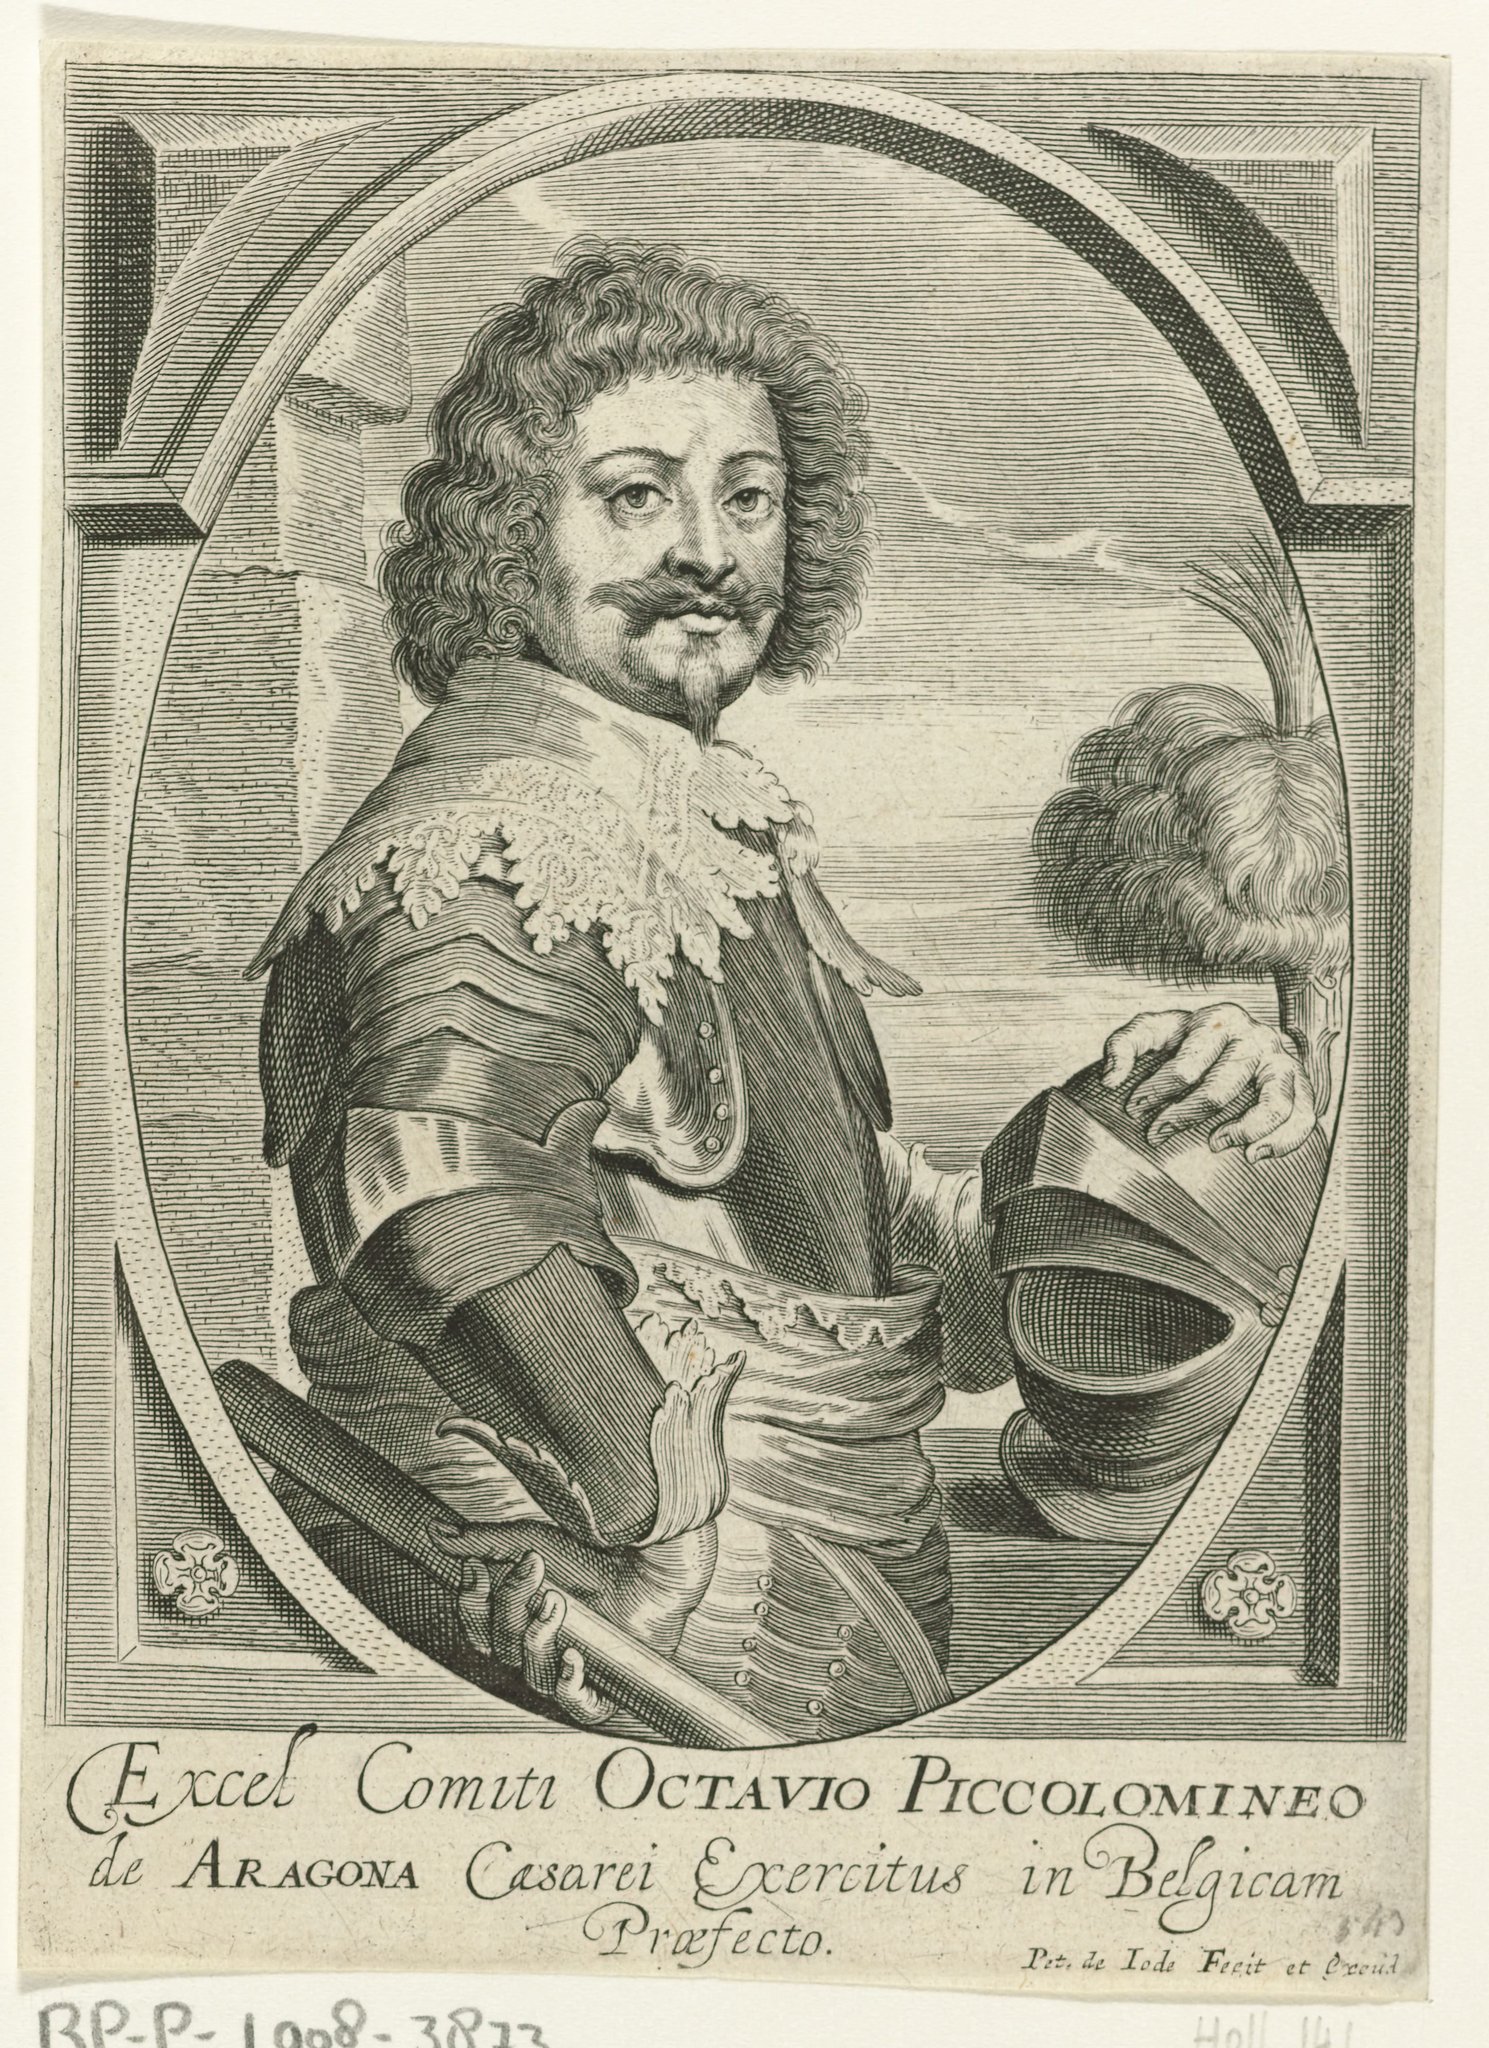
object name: print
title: Theatrum pontificum, imperatorum, regum, ducum, principum, etc.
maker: pieter de jode (ii)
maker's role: draughtsman, print maker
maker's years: 1606-1674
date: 1628-1670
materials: paper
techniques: engraving, etching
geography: antwerp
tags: historical persons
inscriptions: collector's mark: Lugt 2228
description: Portret van Ottavio Picolomini, ten halven lijve. Zijn linkerhand rust op zijn helm en in zijn rechterhand houdt hij een commandostaf. Het portret is gevat in een ovale omlijsting met vierkant randwerk met rozetten. In de marge een drieregelig onderschrift in het Latijn.